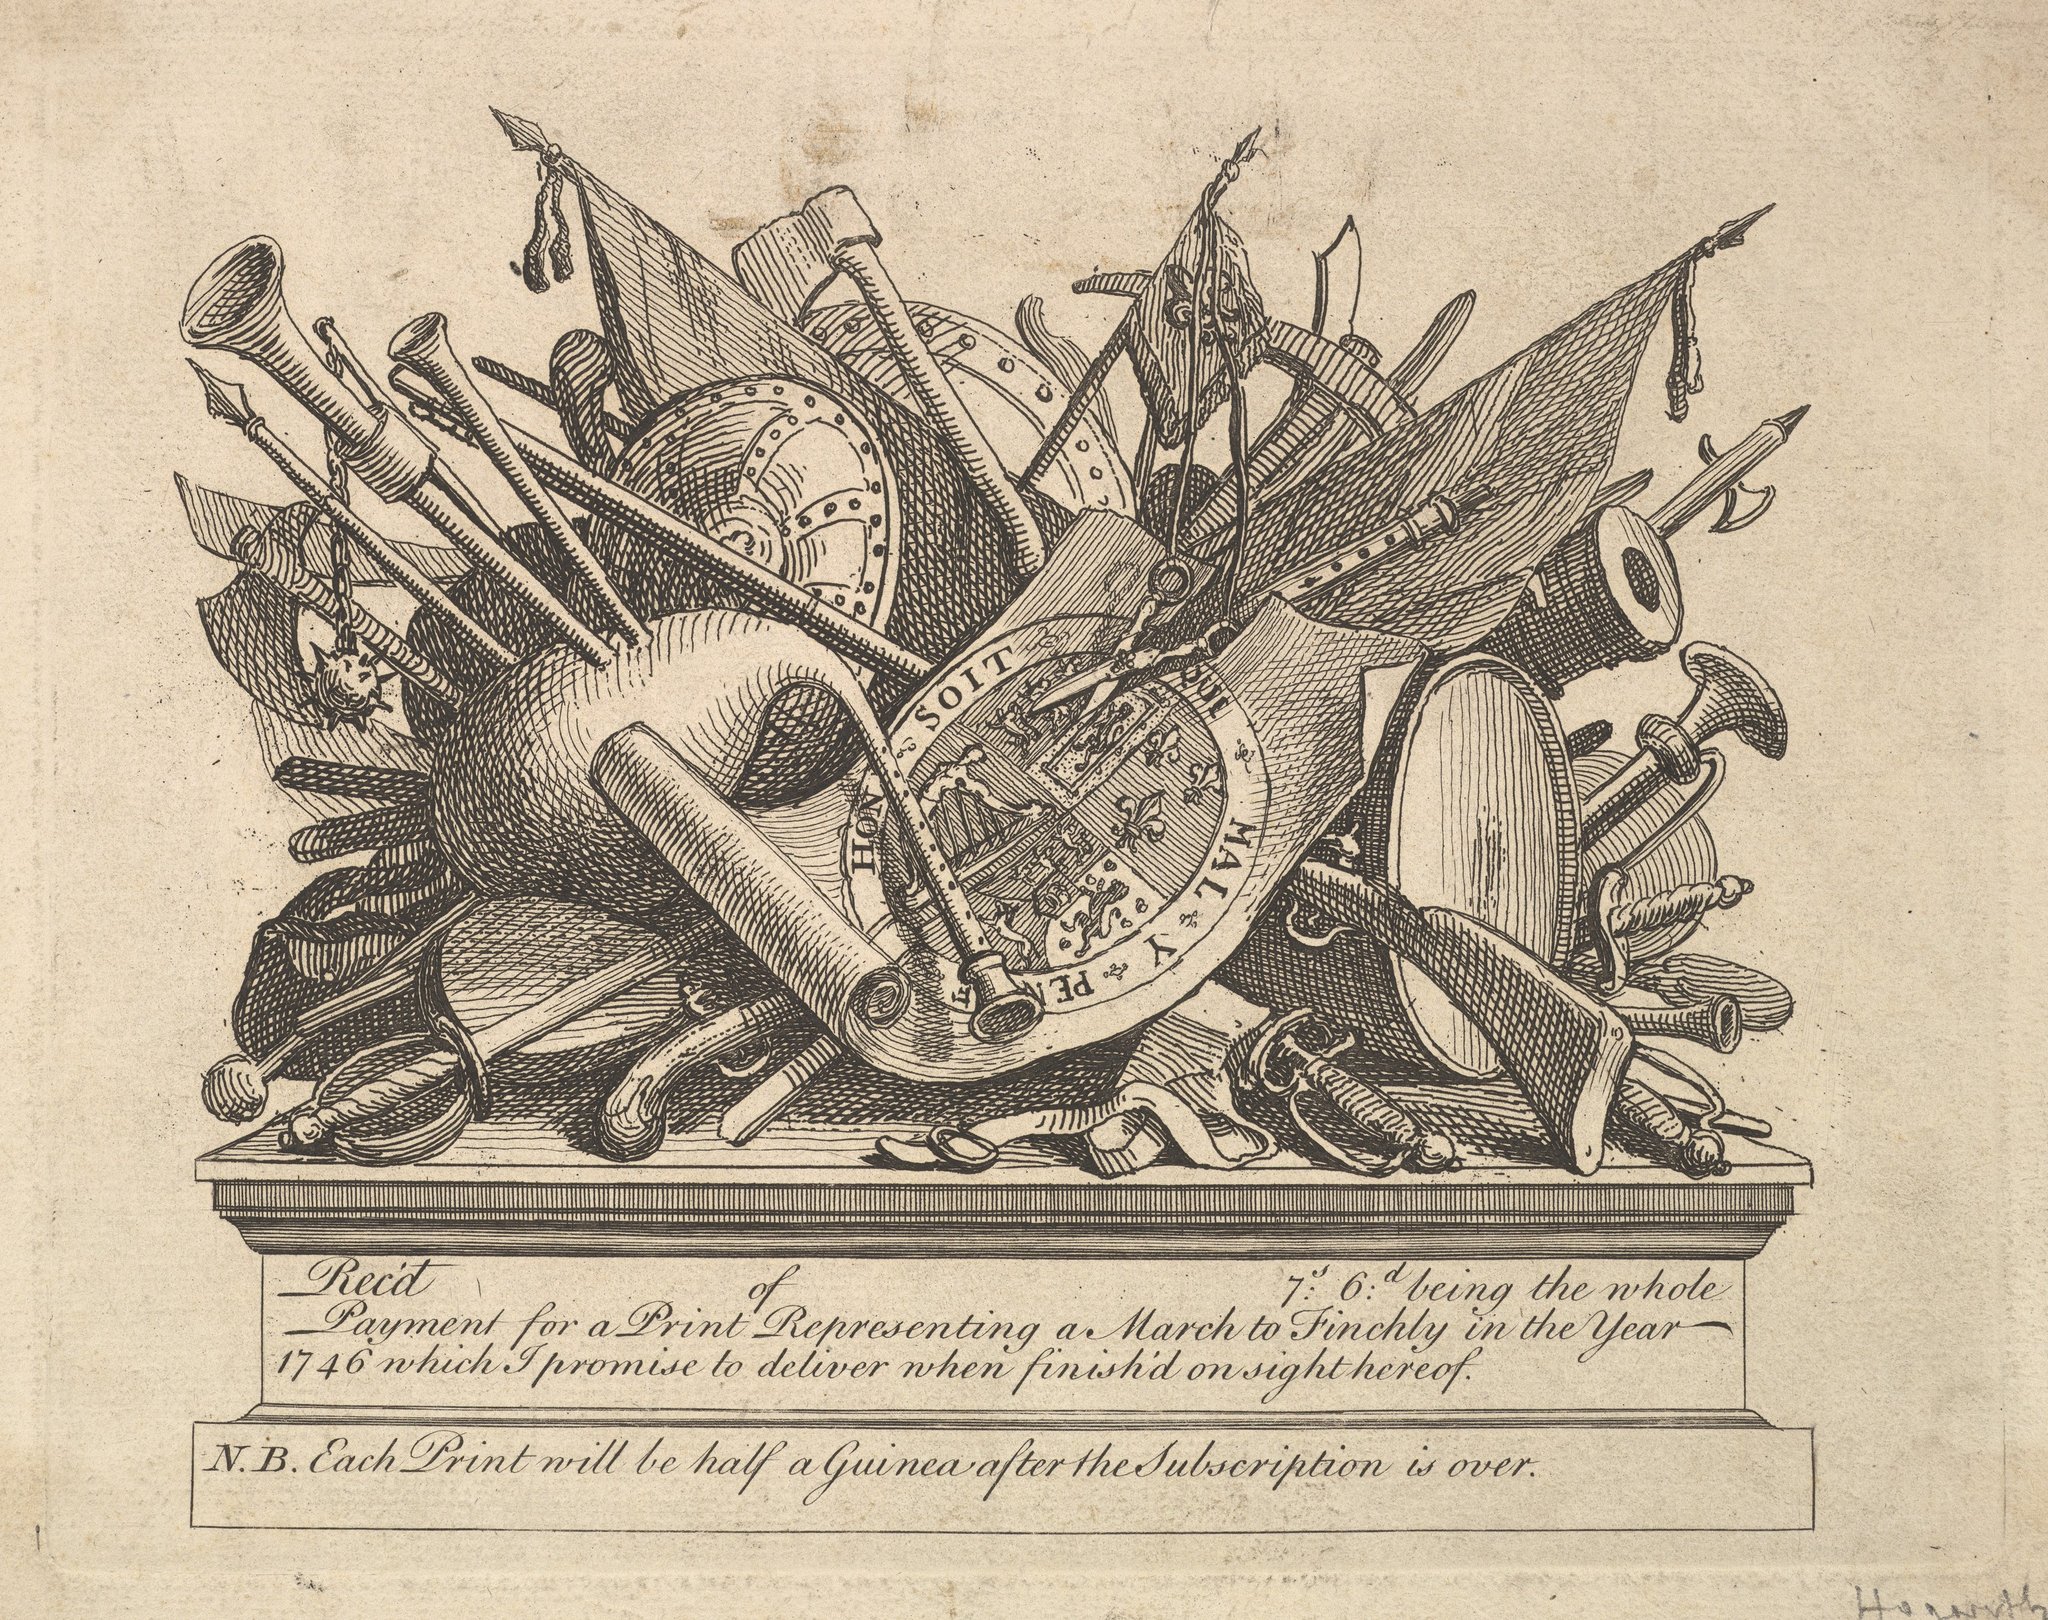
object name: print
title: A Stand of Arms, Musical Instruments, etc.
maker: william hogarth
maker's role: artist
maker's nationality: british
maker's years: 1697-1764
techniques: engraving, etching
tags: weapons,coat of arms